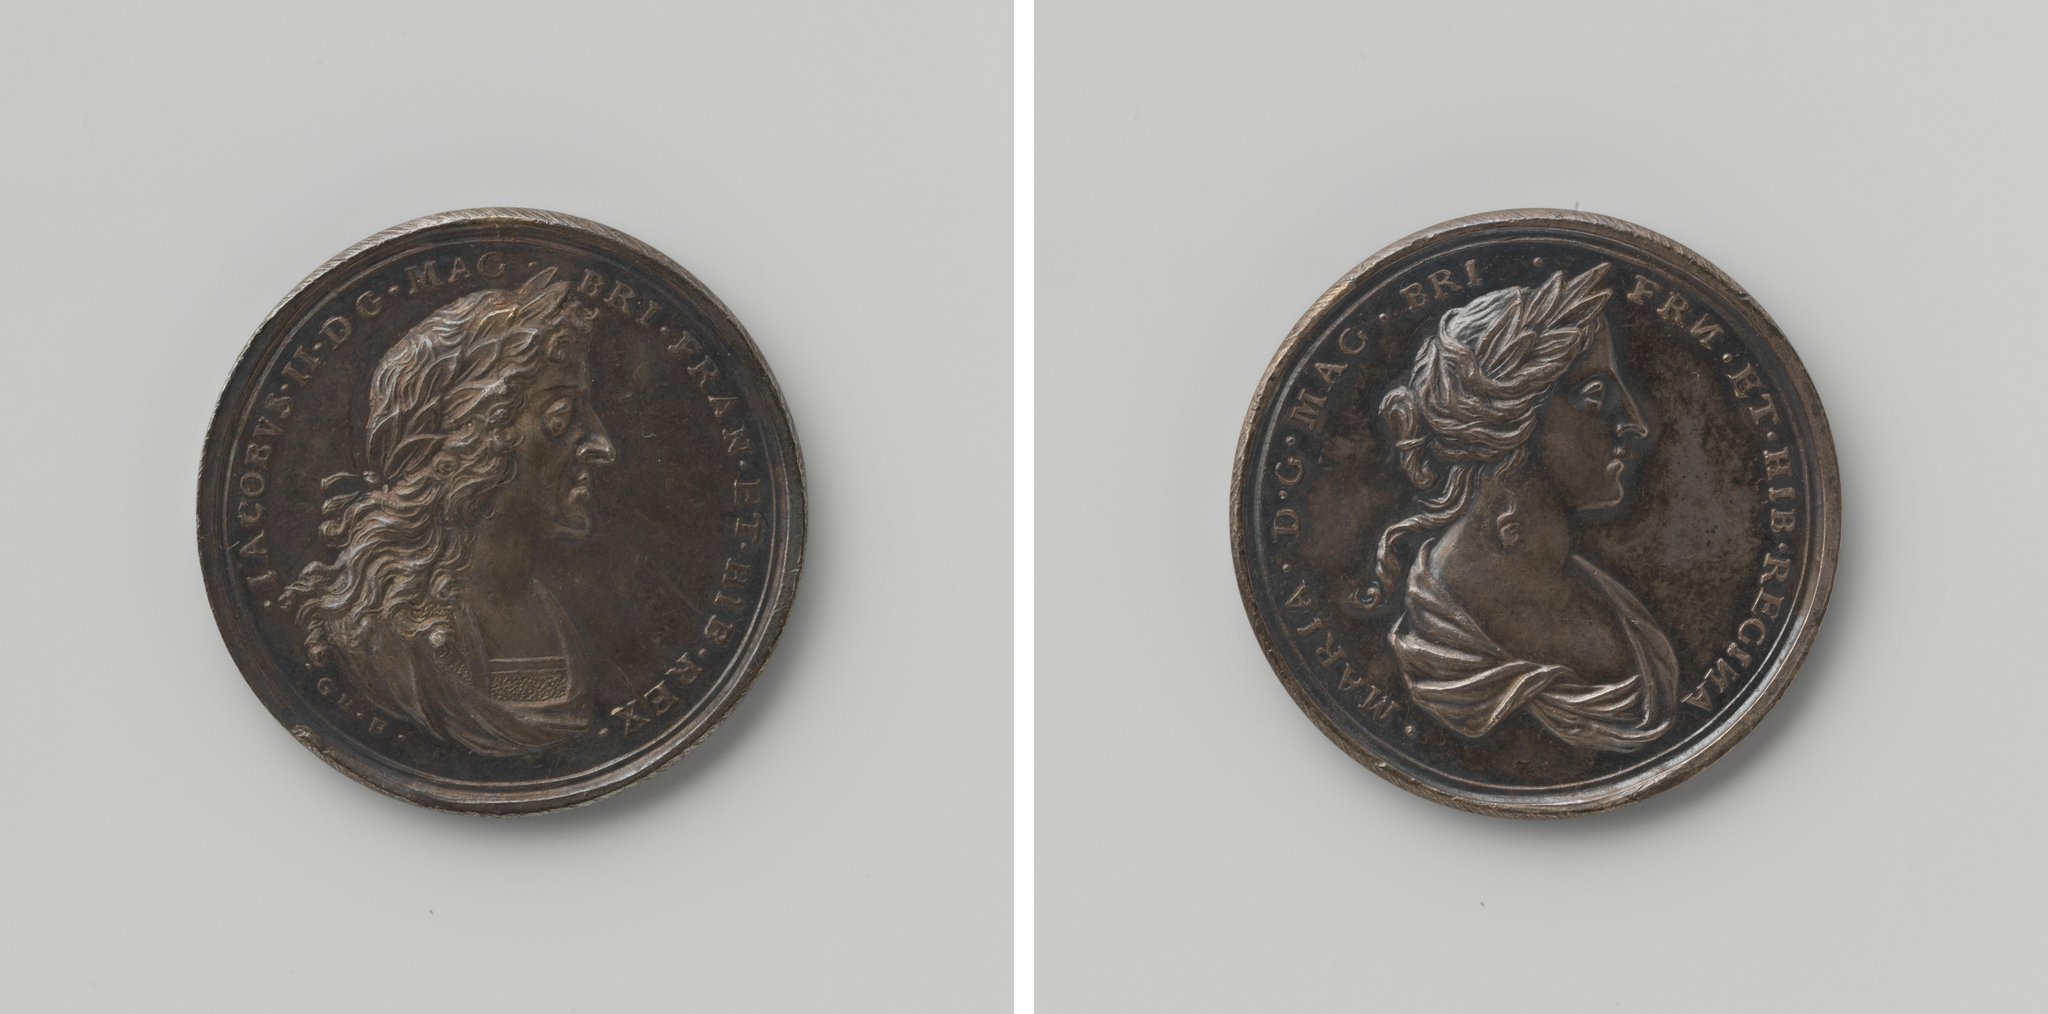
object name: history medal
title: Jacobus II en Maria van Engeland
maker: george bower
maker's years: 1650-1690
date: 1685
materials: silver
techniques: striking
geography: london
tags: jacobus ii (koning van engeland en schotland), paris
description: Zilveren penning. Voorzijde: borststuk man met lauwerkrans binnen omschrift. Keerzijde: borststuk vrouw met lauwerkrans binnen omschrift